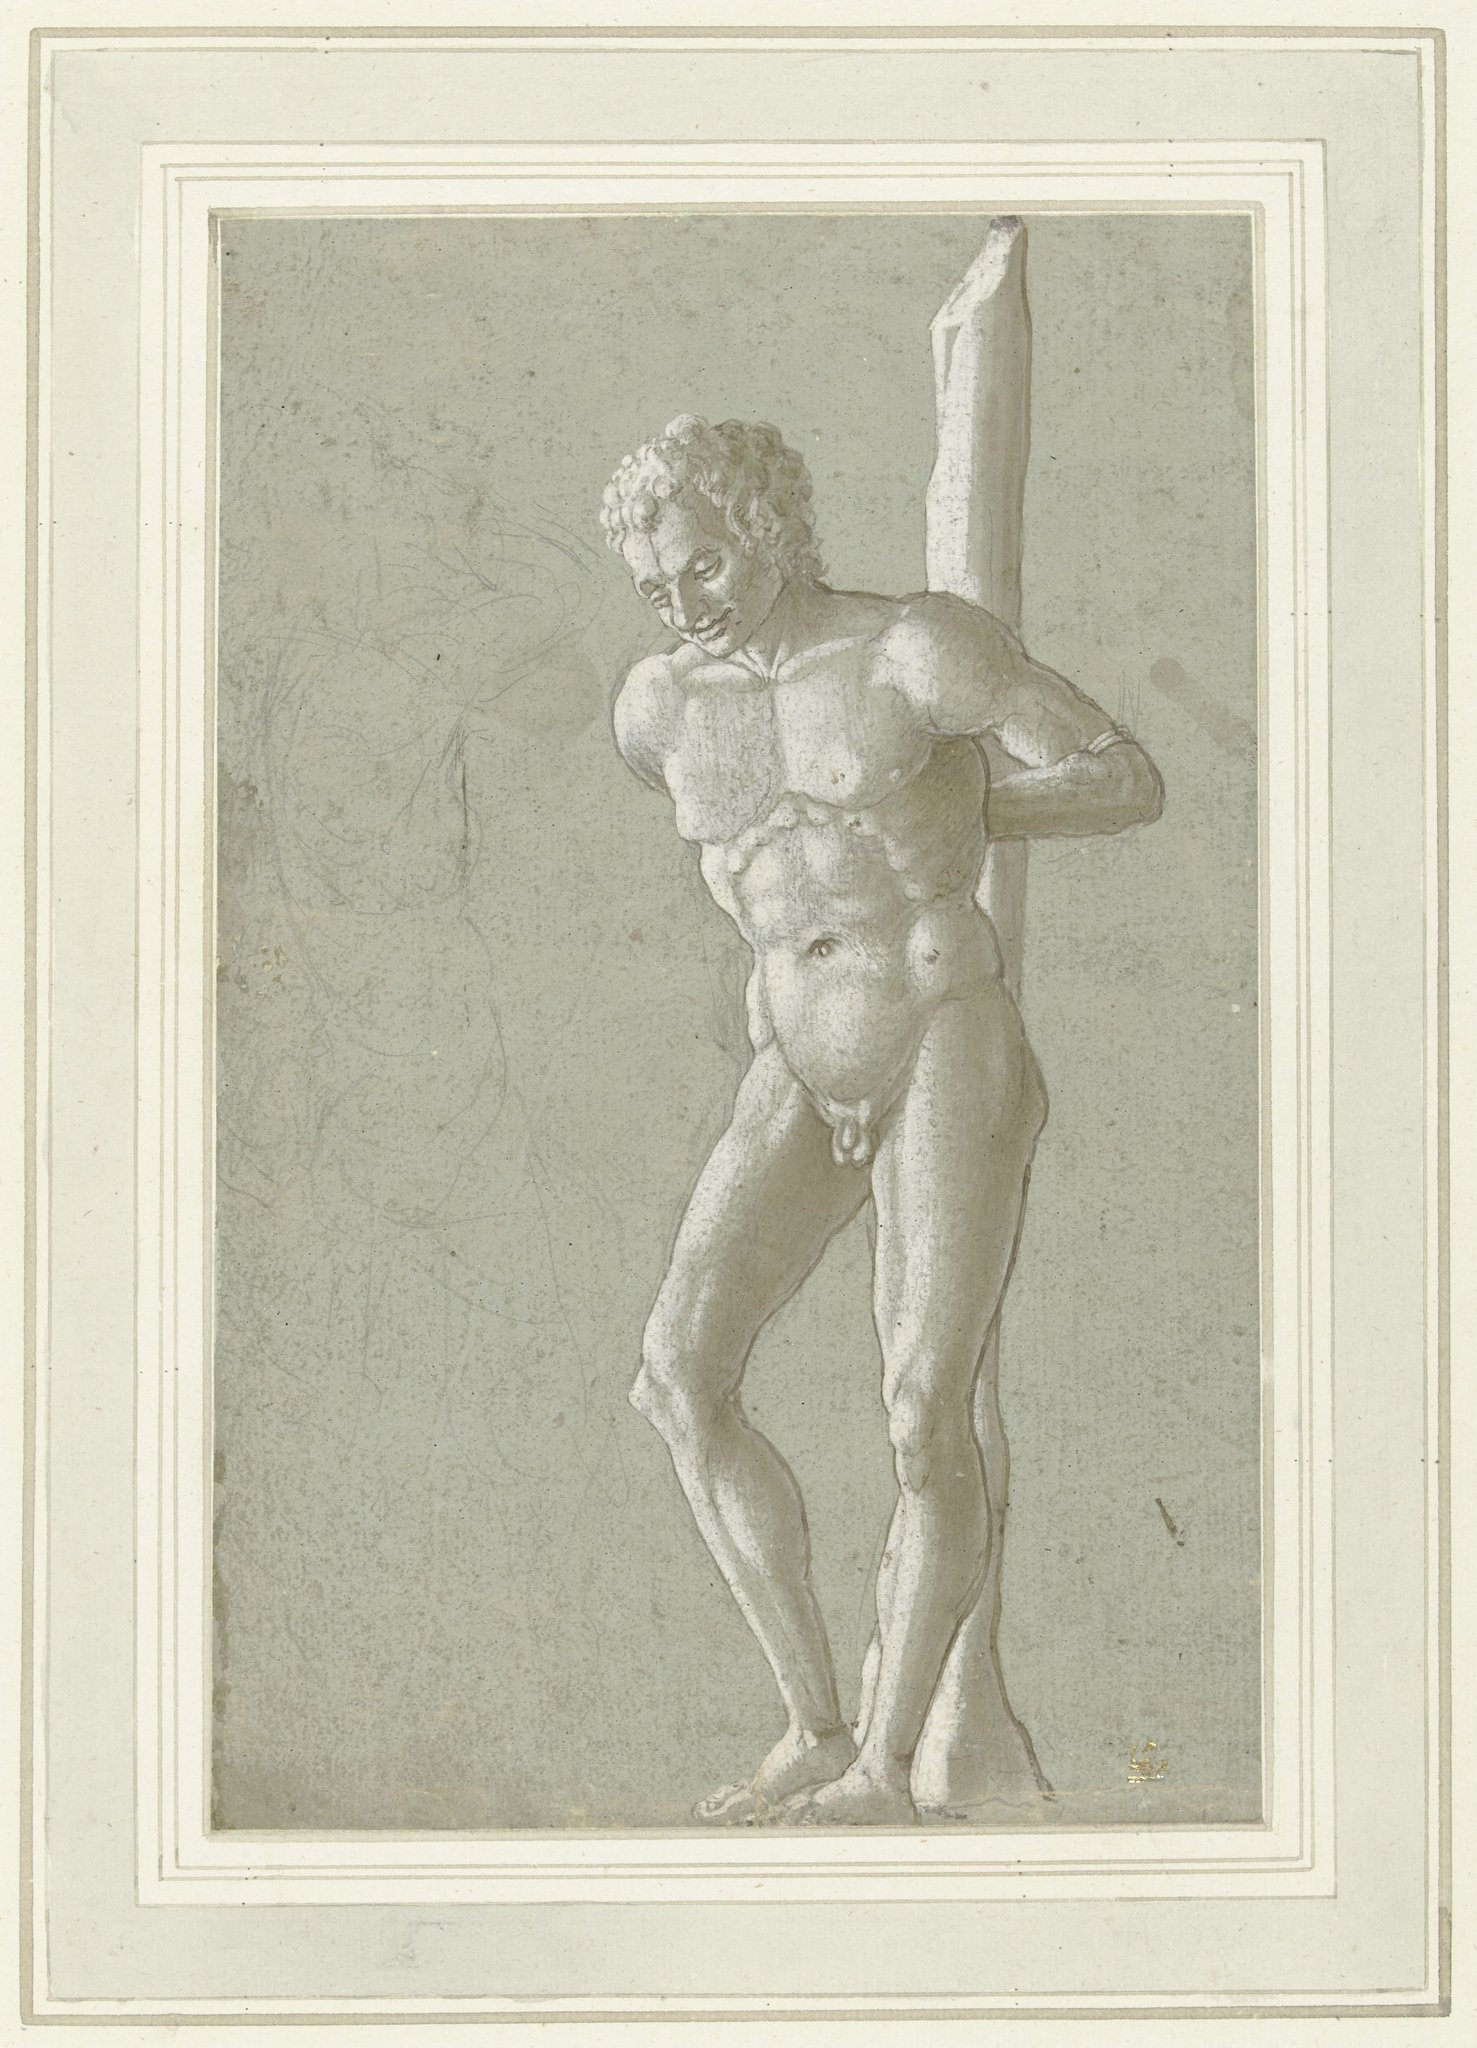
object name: drawing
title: Vastgebonden naakte man en naakte figuur met opgeven arm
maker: marco zoppo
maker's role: draughtsman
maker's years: 1433-1478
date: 1453-1478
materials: ink, paper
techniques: brush, pen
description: Studie van een aan een geselpaal gebonden naakte man (Marsyas?); links een schets van een naakte figuur met opgeheven arm.